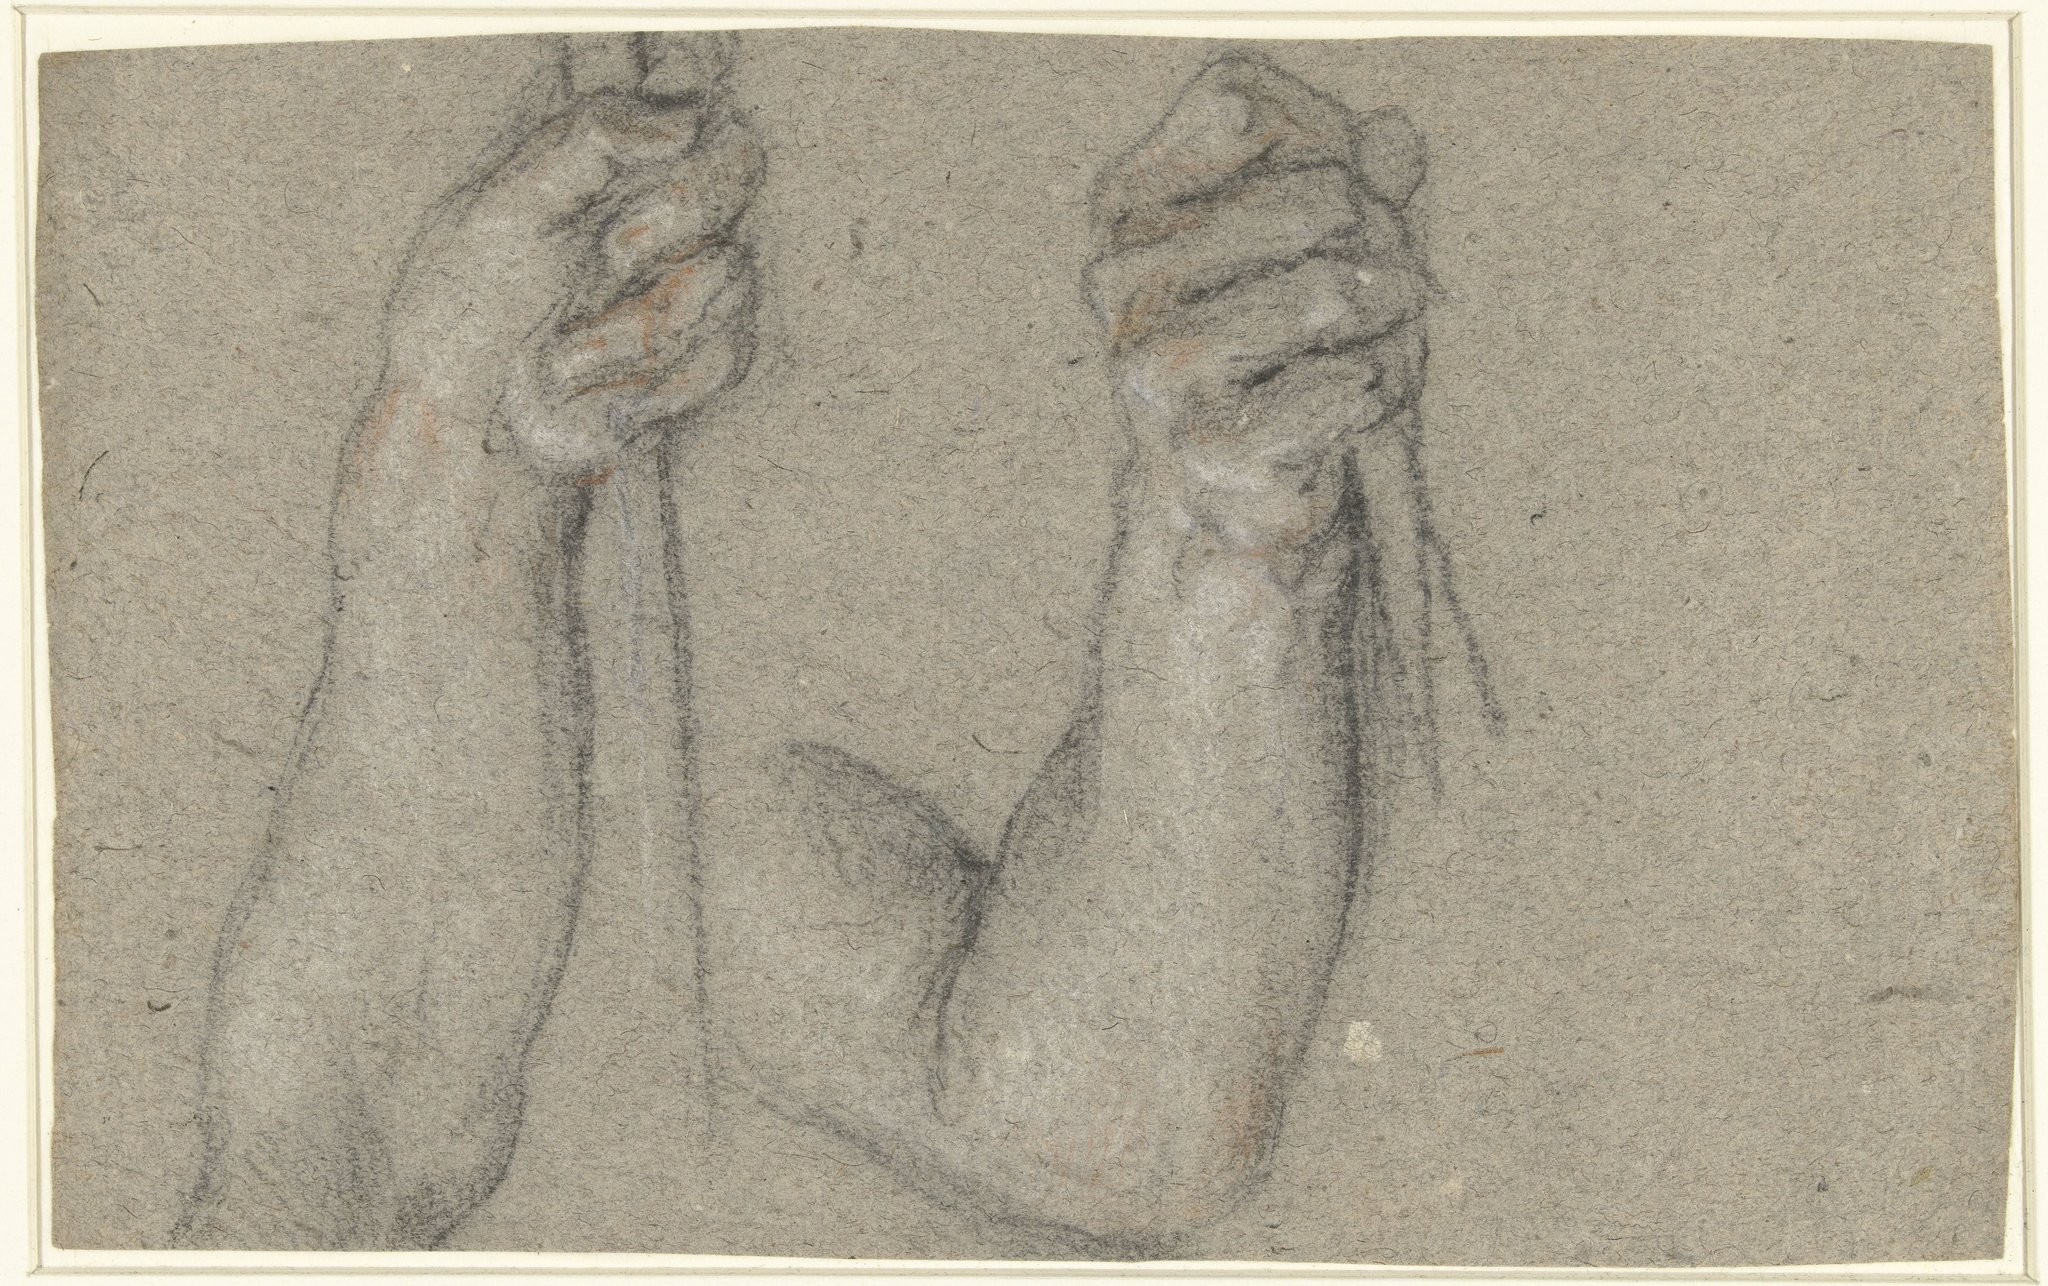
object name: drawing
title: Studieblad met twee handen aan een staf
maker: Anonymous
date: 1590-1600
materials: paper, chalk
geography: northern italy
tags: arms, hand